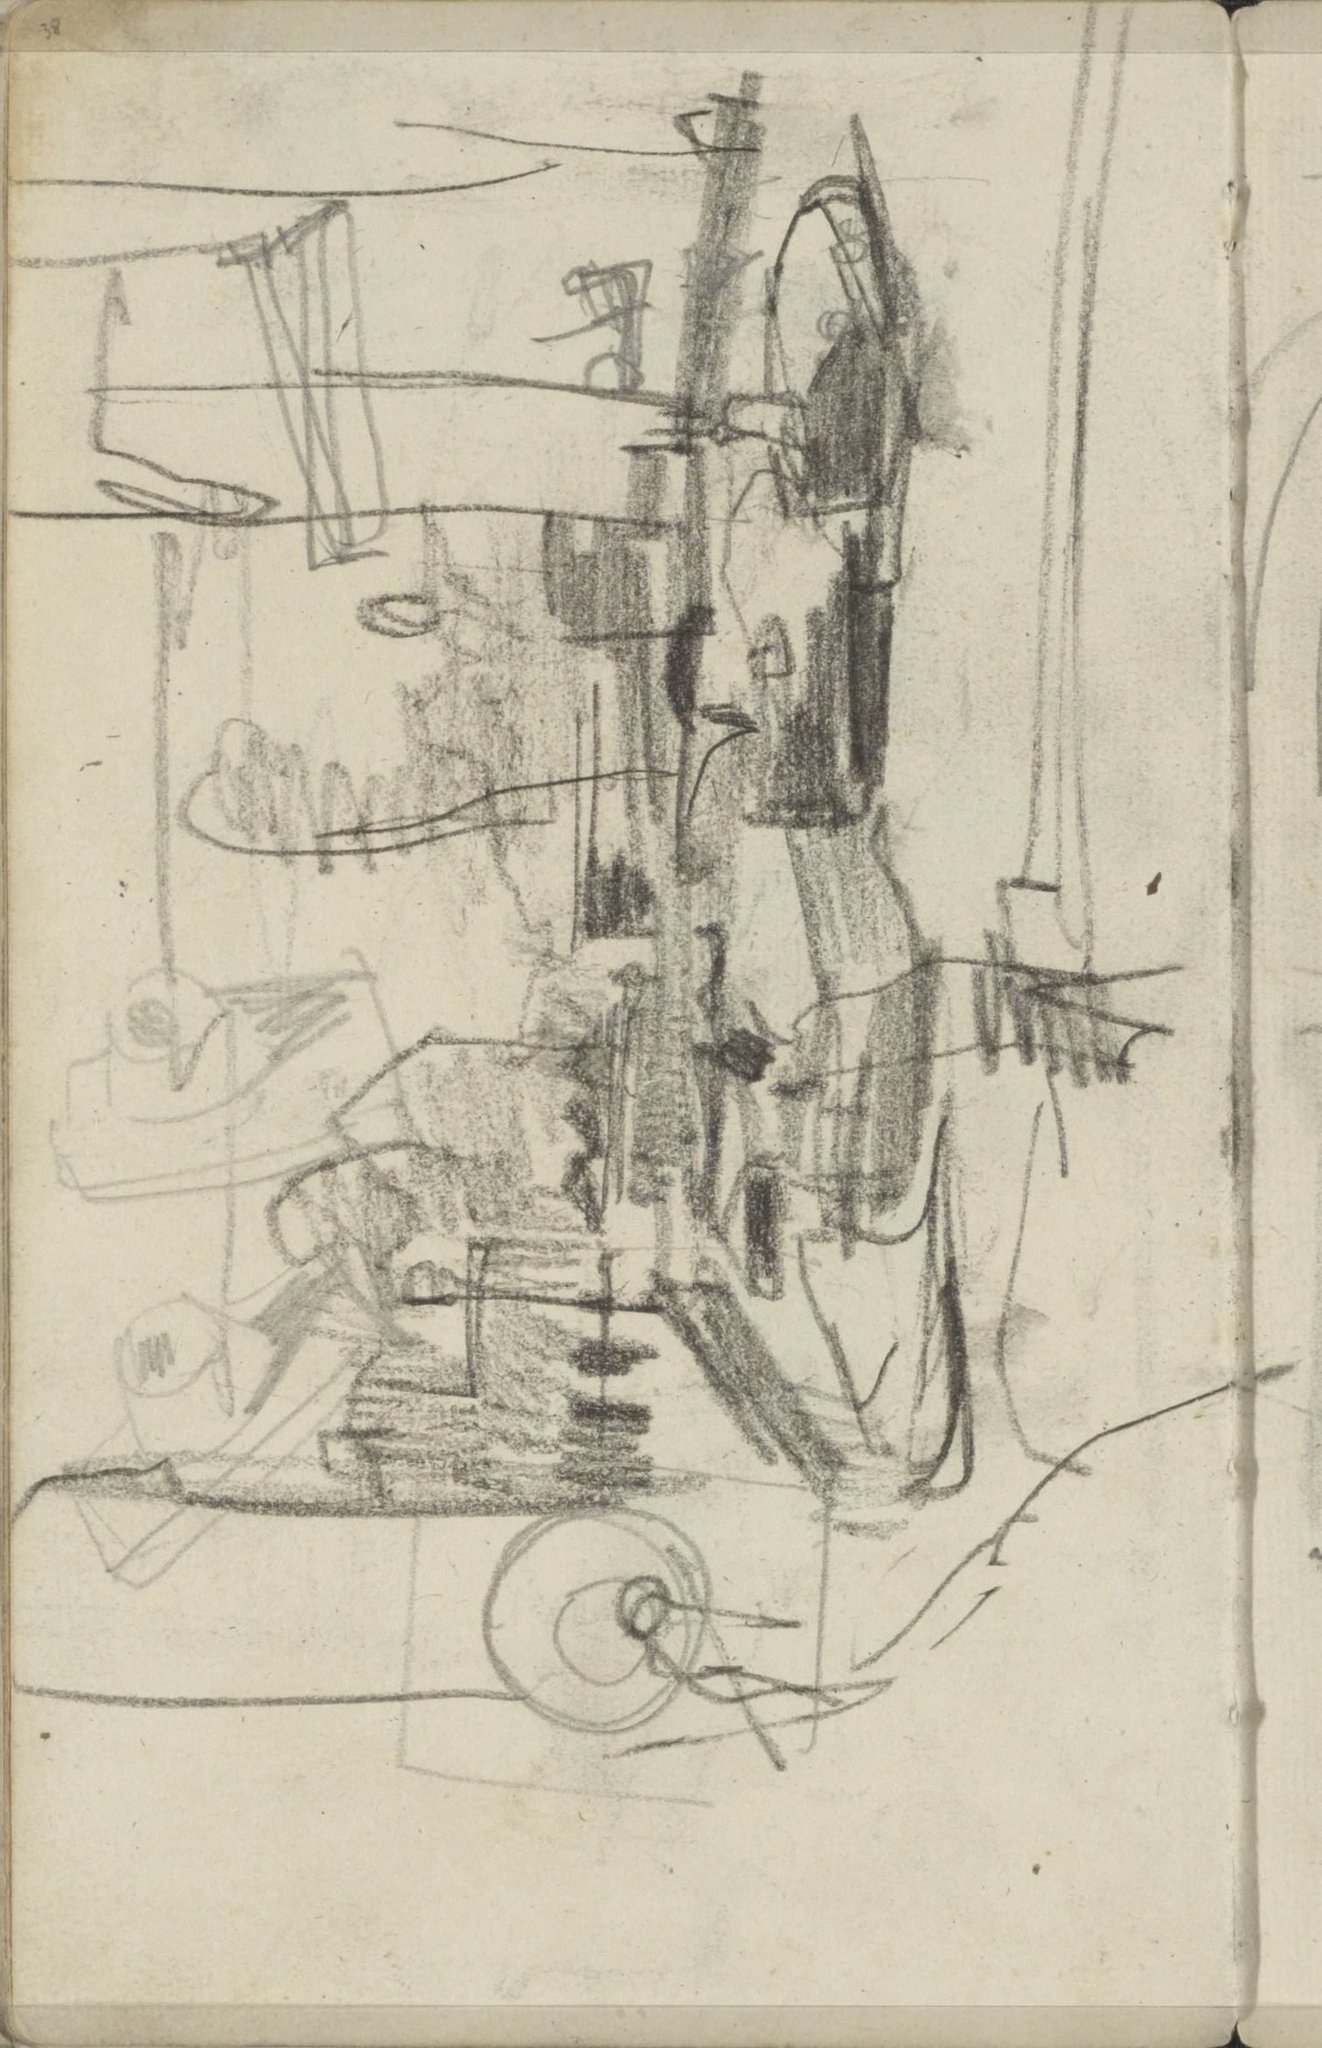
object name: sketchbook leaf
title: Stadsgezicht met water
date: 1881-1883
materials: chalk, paper, pencil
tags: ships (in general), civic architecture; edifices; dwellings, canals, waters (in city) (+ city(-scape) with figures, staffage)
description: Pagina 38 uit een schetsboek met 29 bladen.